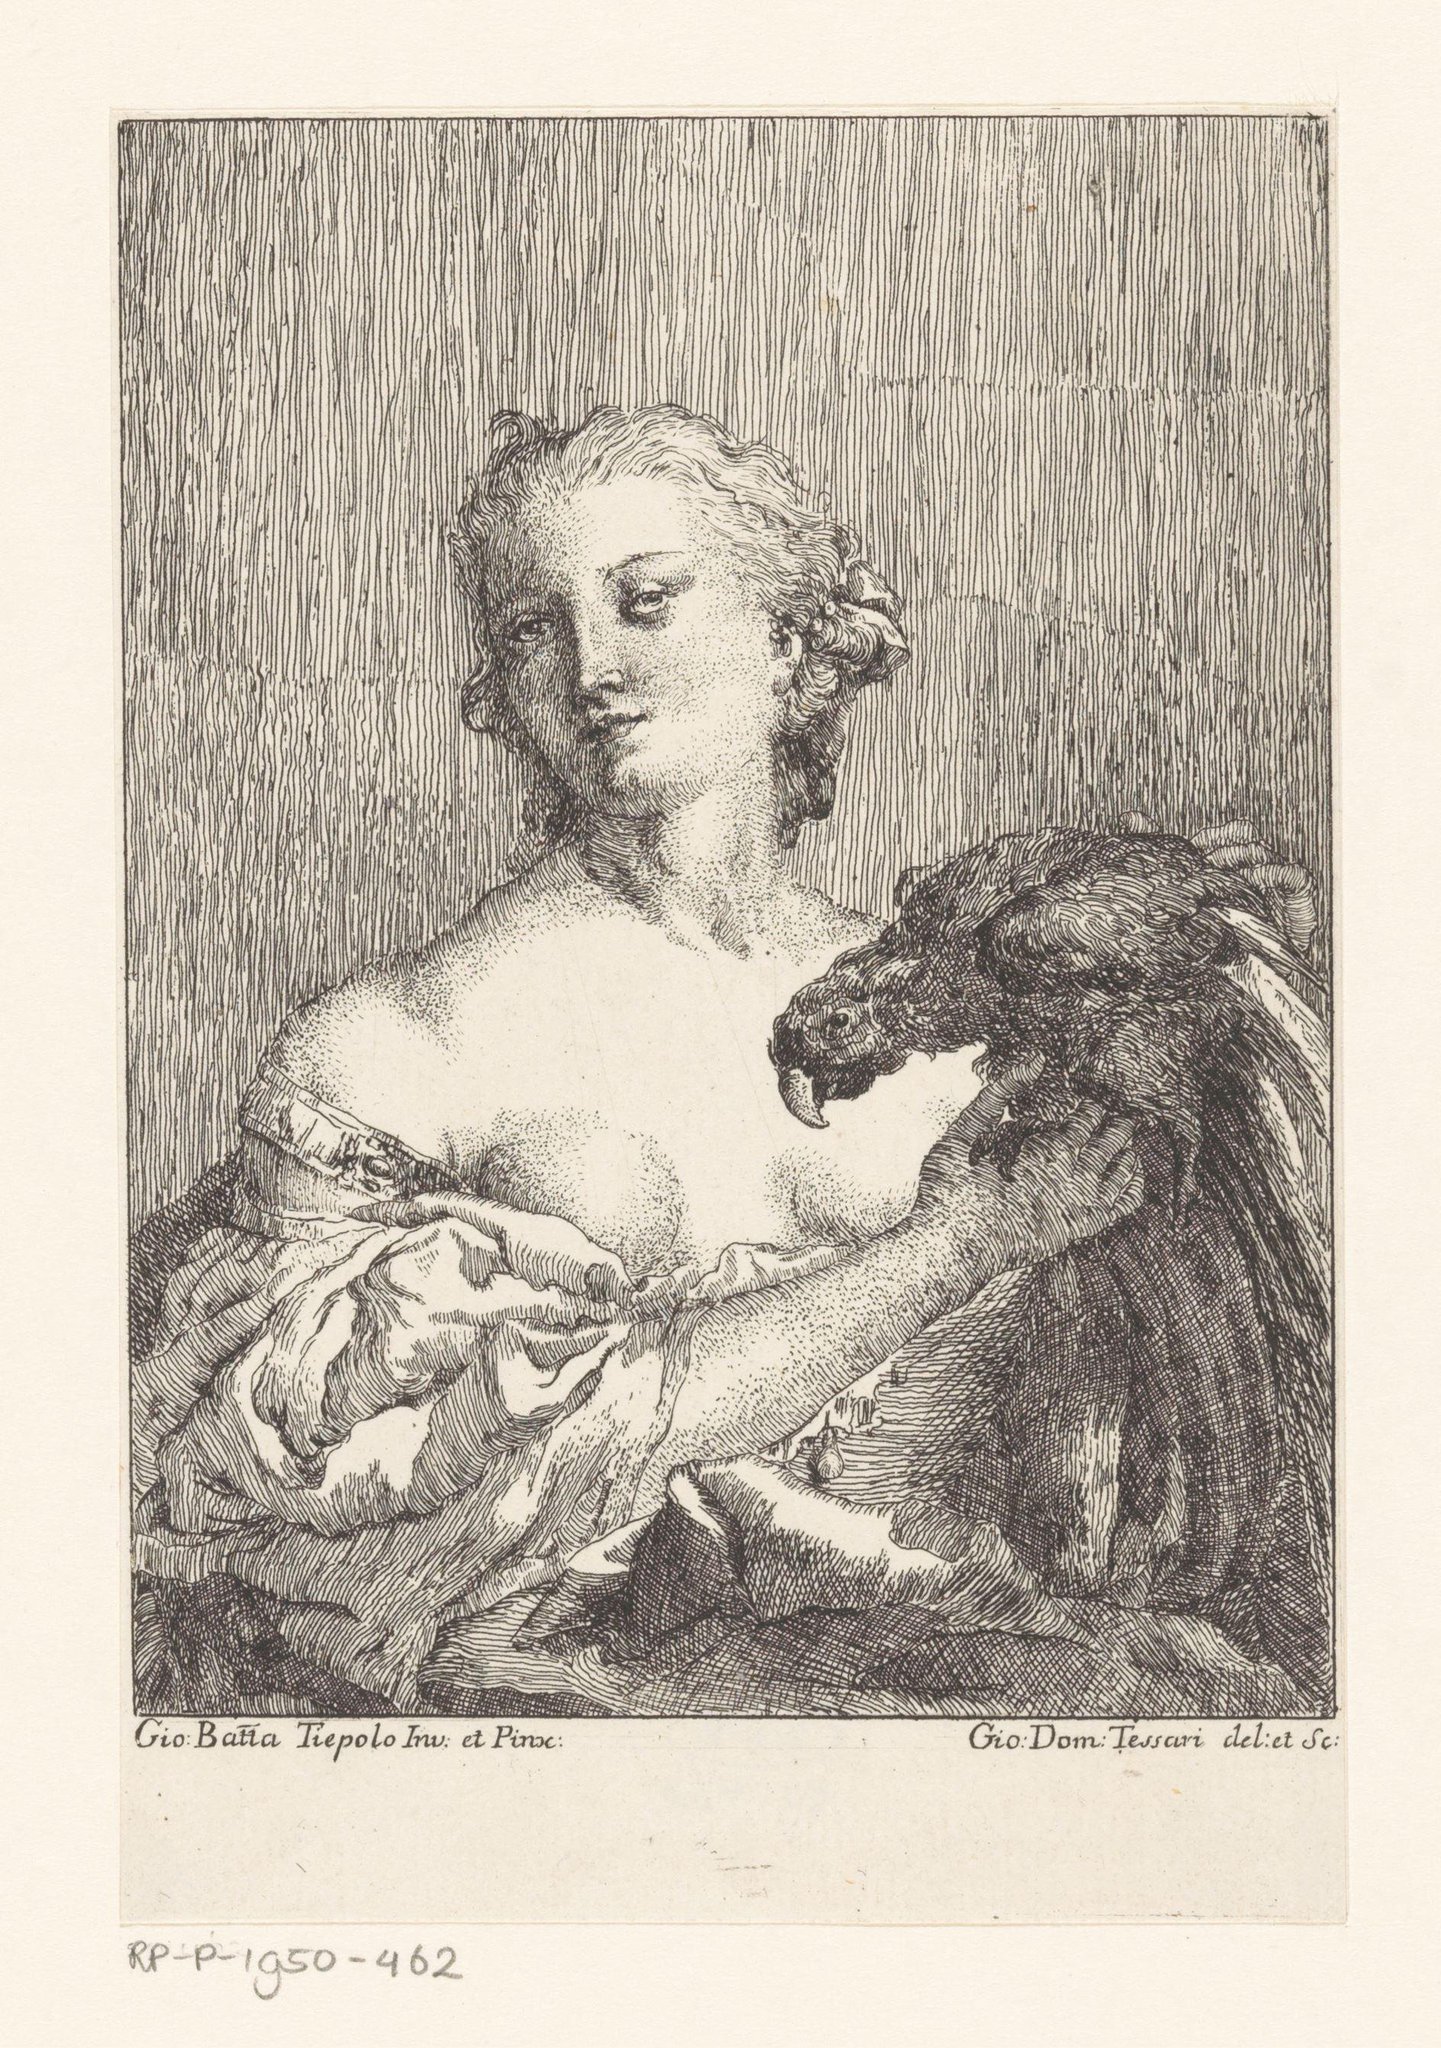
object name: print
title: Vrouw met papegaai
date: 1740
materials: paper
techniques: etching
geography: italy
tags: anonymous historical persons portrayed in a double portrait - bb - woman, ornamental birds: parrot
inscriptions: collector's mark: Lugt 2228